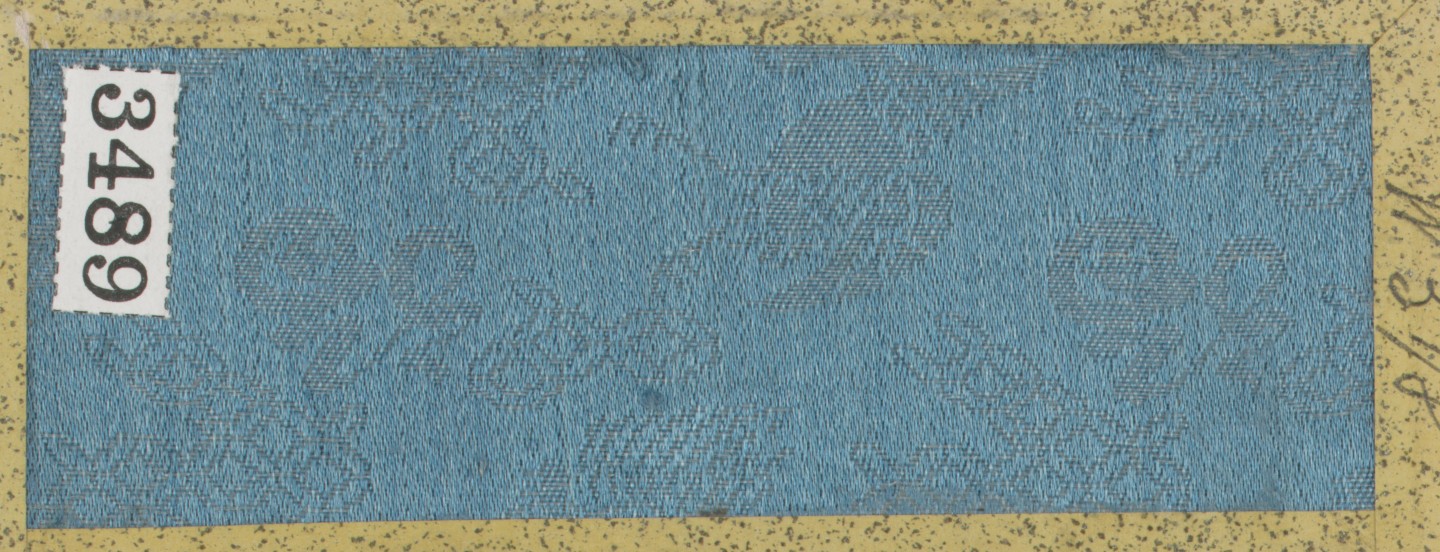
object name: sample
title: Textile Sample from Sample Book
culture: japanese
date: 1801-1900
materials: silk